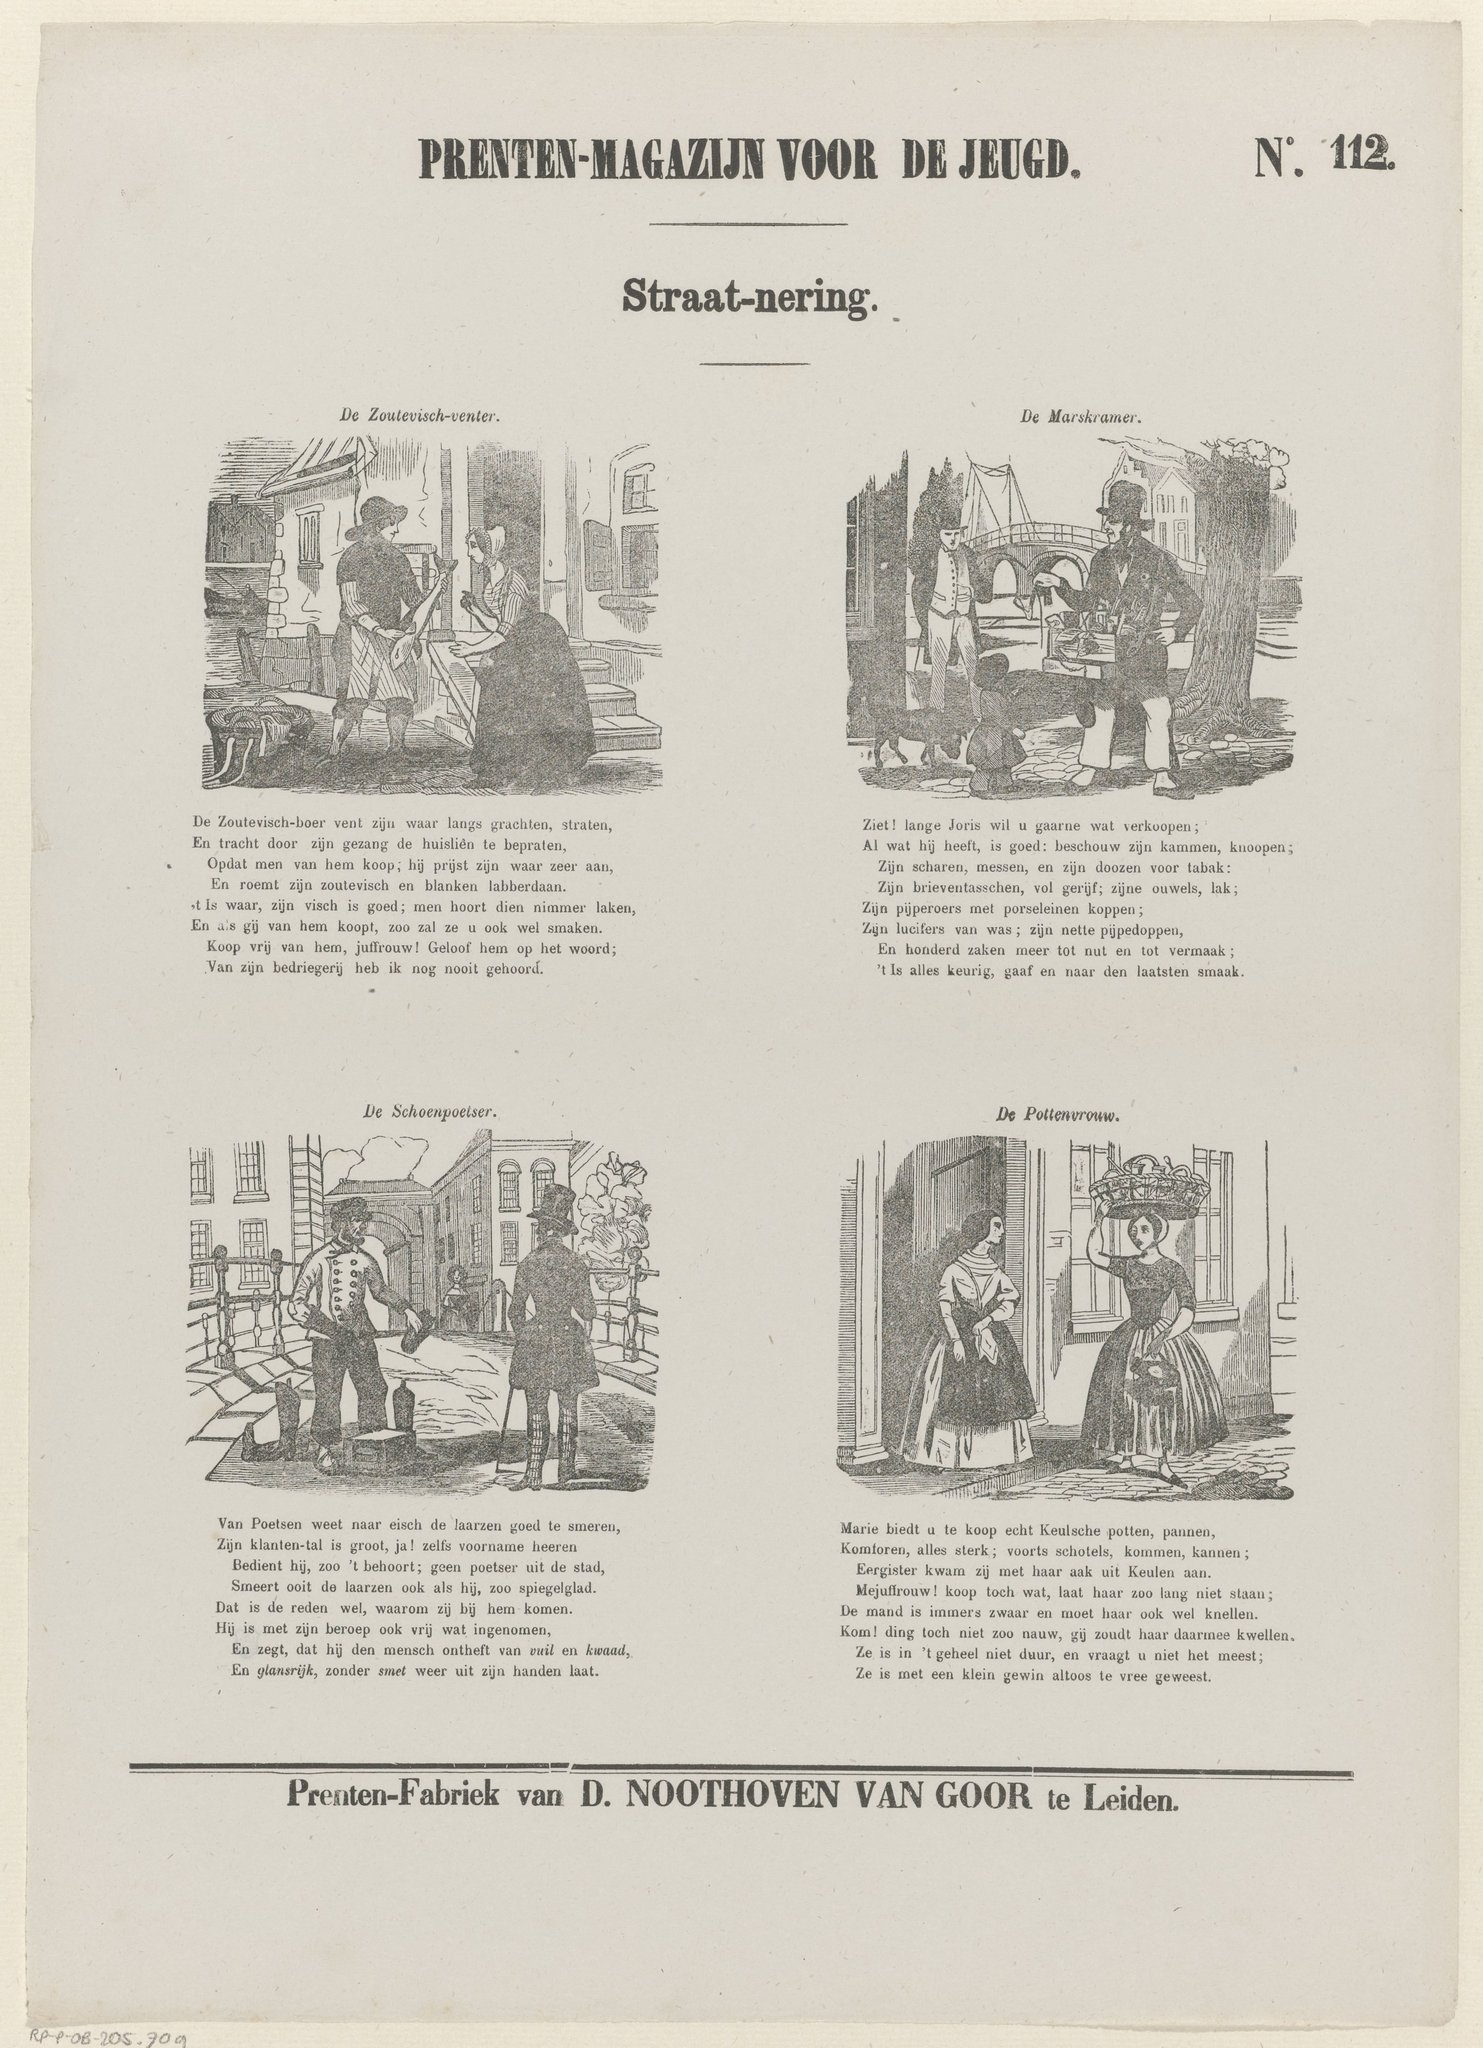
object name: print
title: Prenten-magazijn voor de jeugd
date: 1850-1881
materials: paper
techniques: letterpress printing, engraving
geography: netherlands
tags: street-trader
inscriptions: collector's mark: Lugt 2760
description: Blad met 4 voorstellingen van straatverkopers: een visverkoper, een marskramer, een schoenpoetser en een pottenverkoopster. Boven elke afbeelding een titel, onder elke afbeelding een achtregelig vers. Genummerd rechtsboven: No. 112.